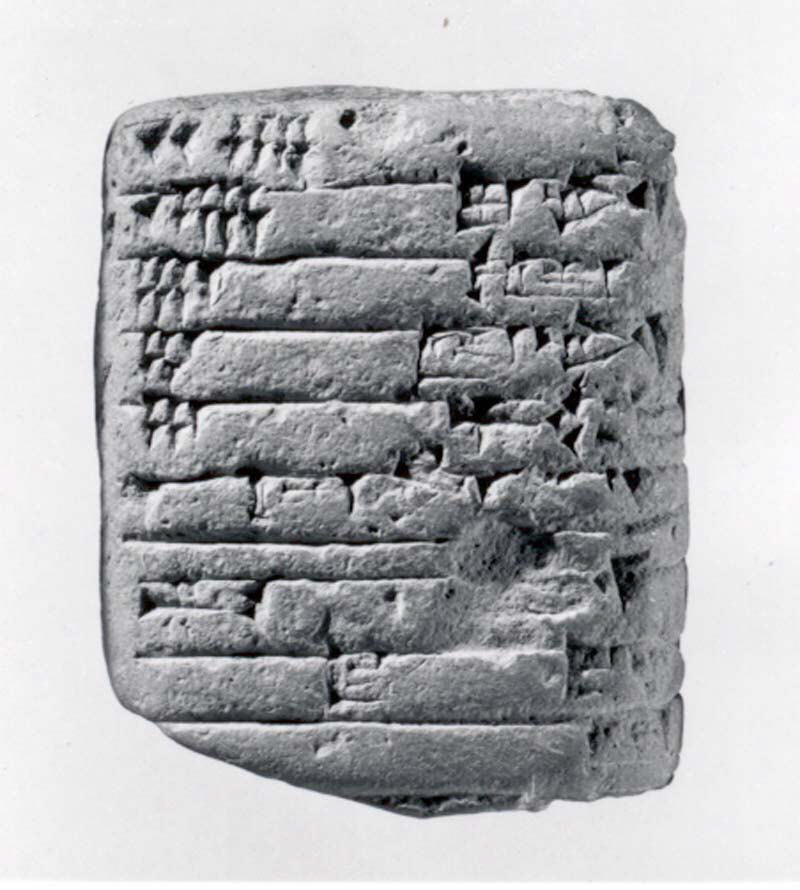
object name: cuneiform tablet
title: Cuneiform tablet: inventory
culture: neo-sumerian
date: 2045 BCE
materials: clay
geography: mesopotamia